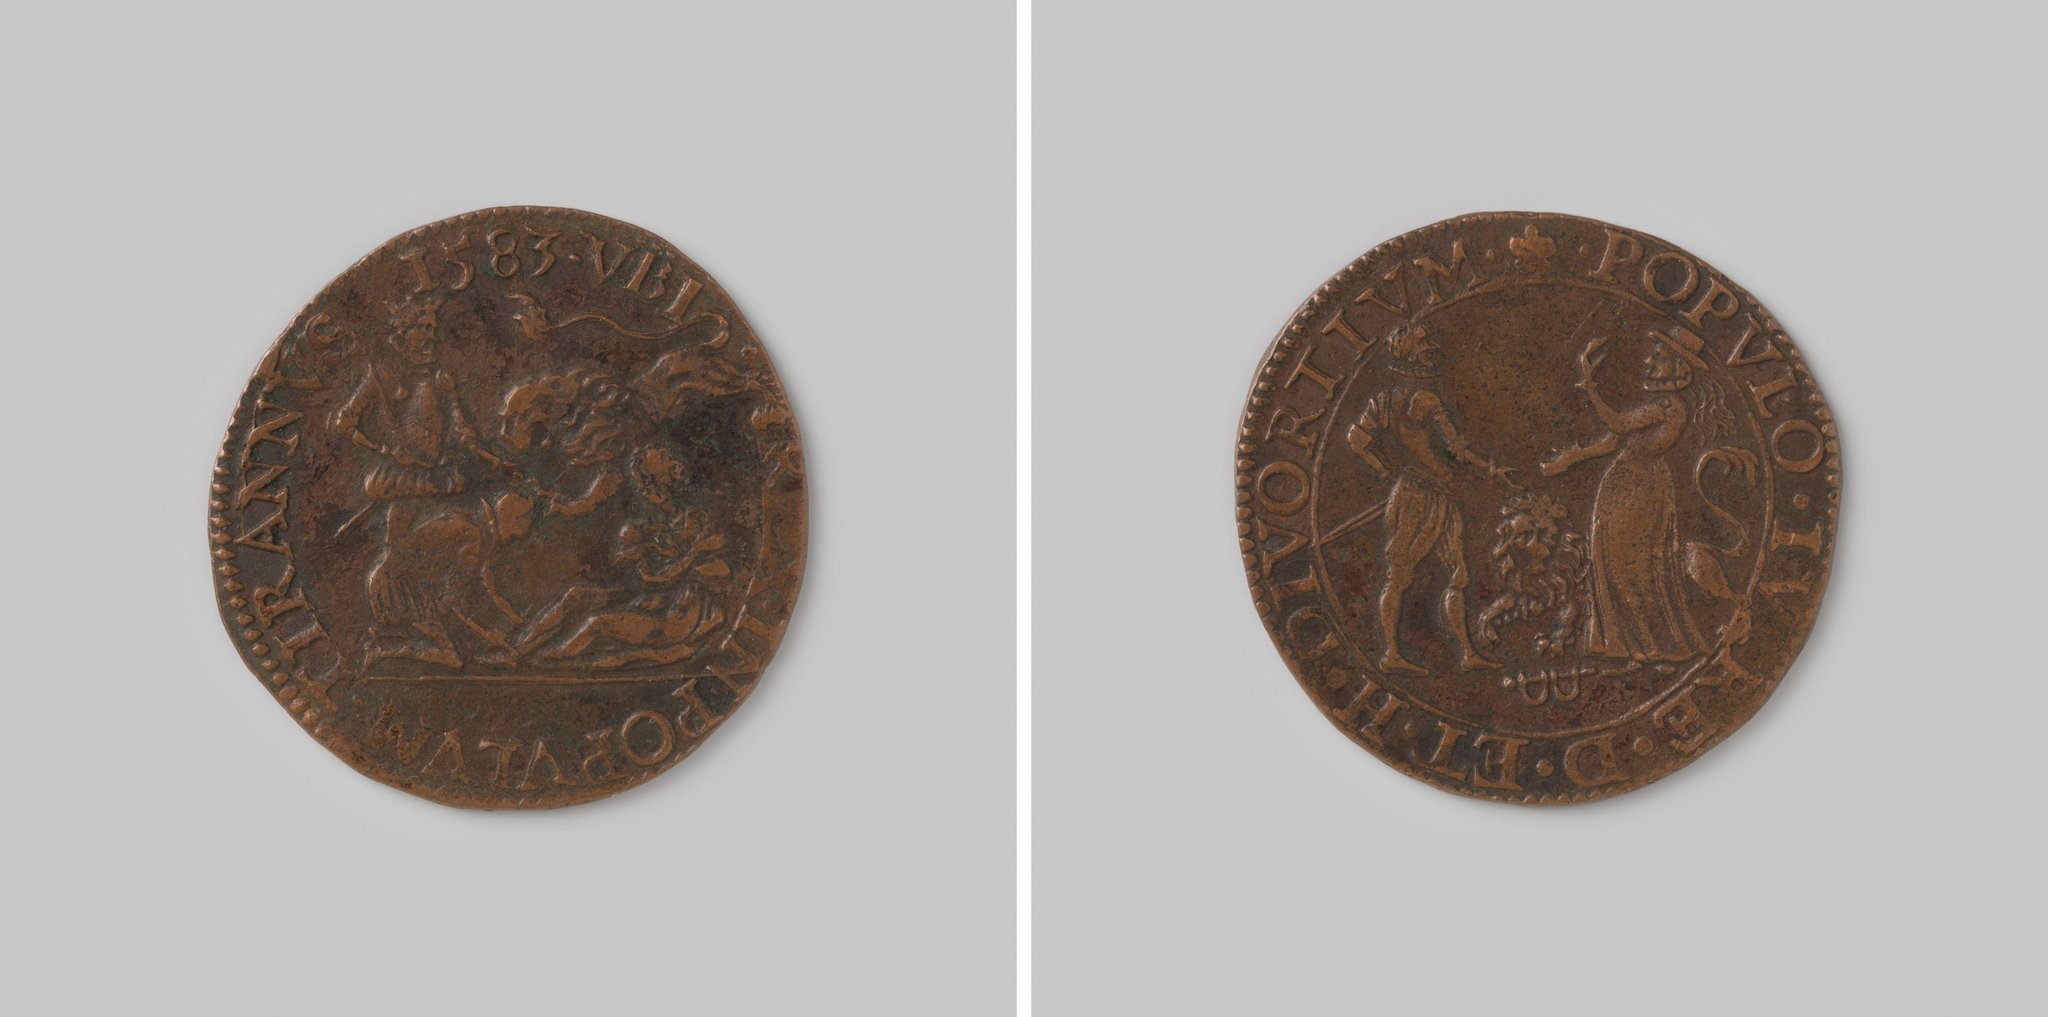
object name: history medal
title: Rekenpenning uit Dordrecht op de afkeer van de Nederlanders tegen de Hertog van Anjou 1583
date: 1583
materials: copper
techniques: striking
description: Koperen penning, op de voorzijde een leeuw die de Hertog van Anjou bespringt die de Nederlanden, als liggende vrouw, de voeten kluistert, waarbij de Spaanse koning toekijkt, met omschrift, op de keerzijde de Nederlanden, als vrouw met hoed met een leeuw aan haar zijde, die Anjou afwijst, met omschrift.